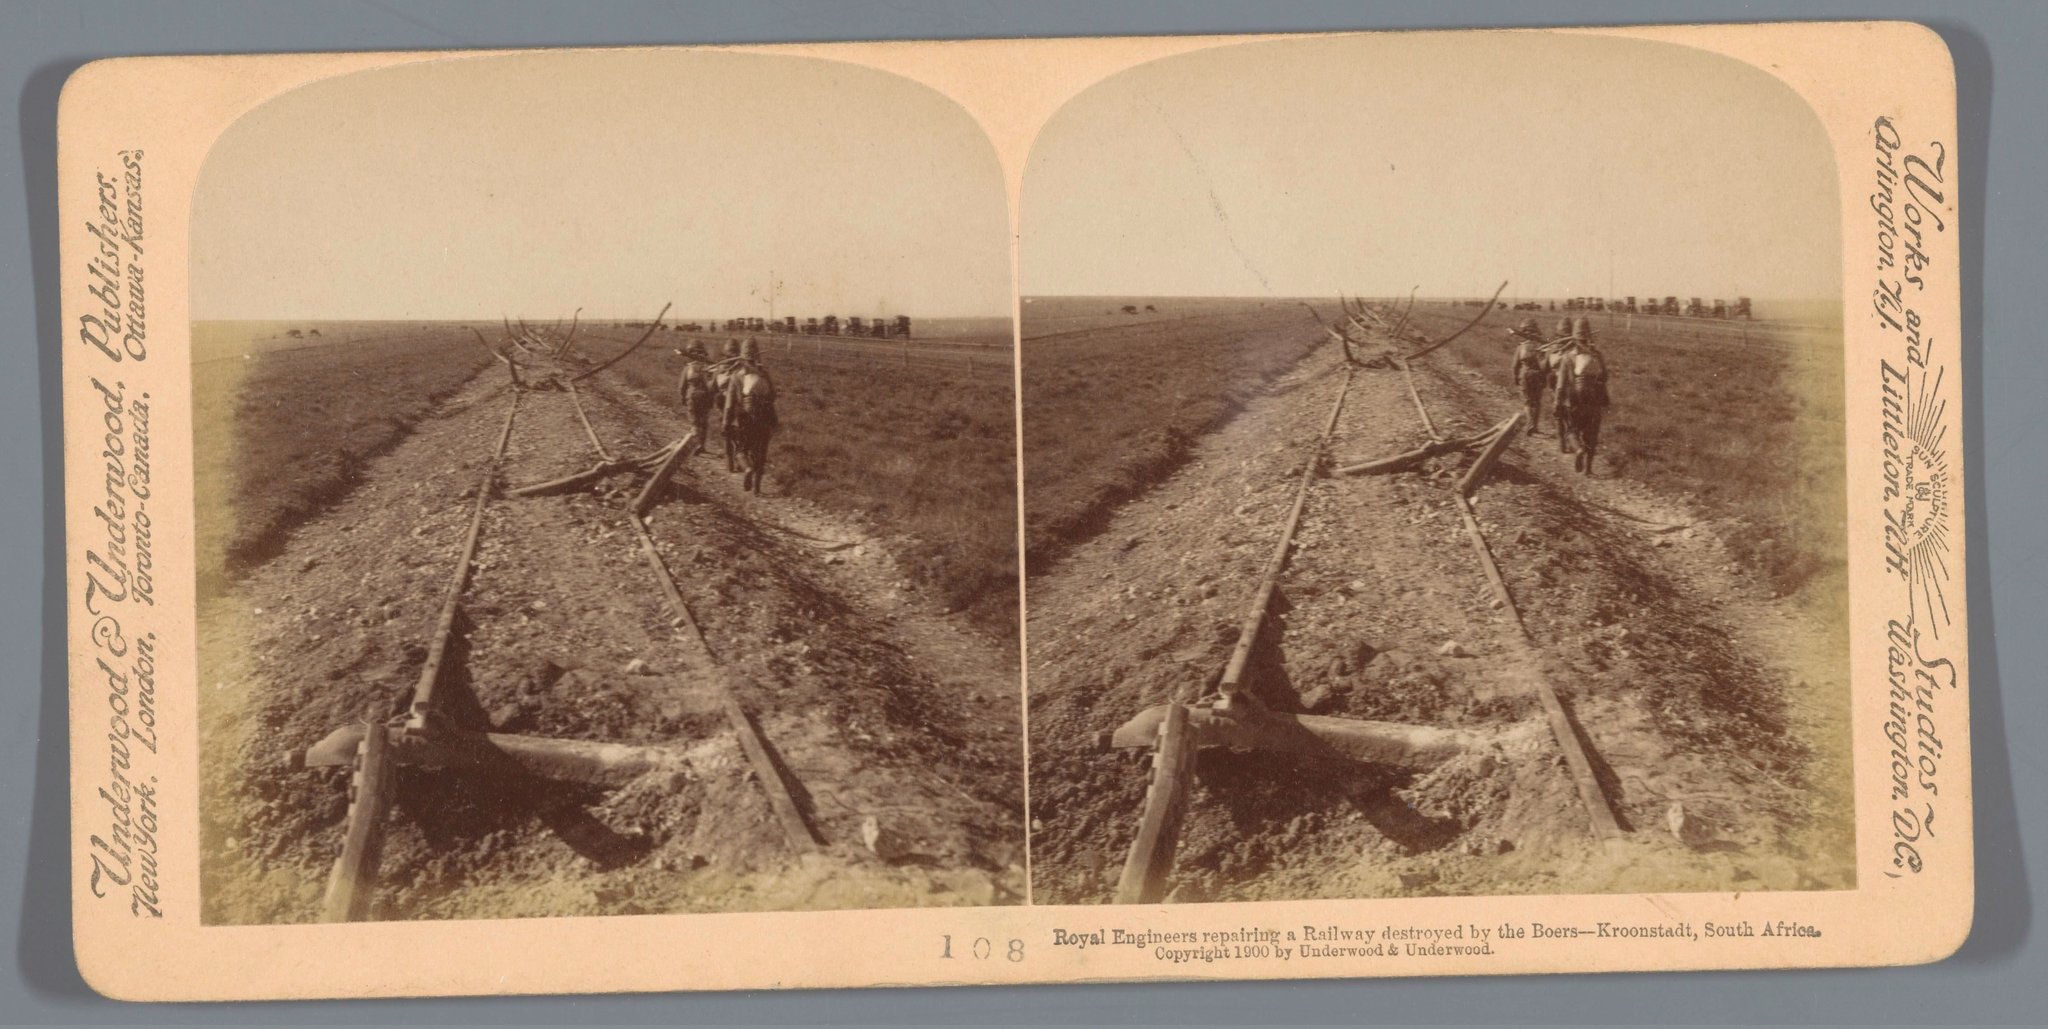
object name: stereograph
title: Reparaties aan de spoorlijn naar Kroonstad, Zuid-Afrika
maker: Anonymous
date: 1900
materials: cardboard, paper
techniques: albumen print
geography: new york city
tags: military engineering ~ communication and transport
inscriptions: inscription: ‘Works and Studios ~/ Arlington, N.J. Littleton, N.H. Washington, D.C.’, inscription, number: ‘108’, copyright notice: ‘Copyright 1900 by Underwood & Underwood.’